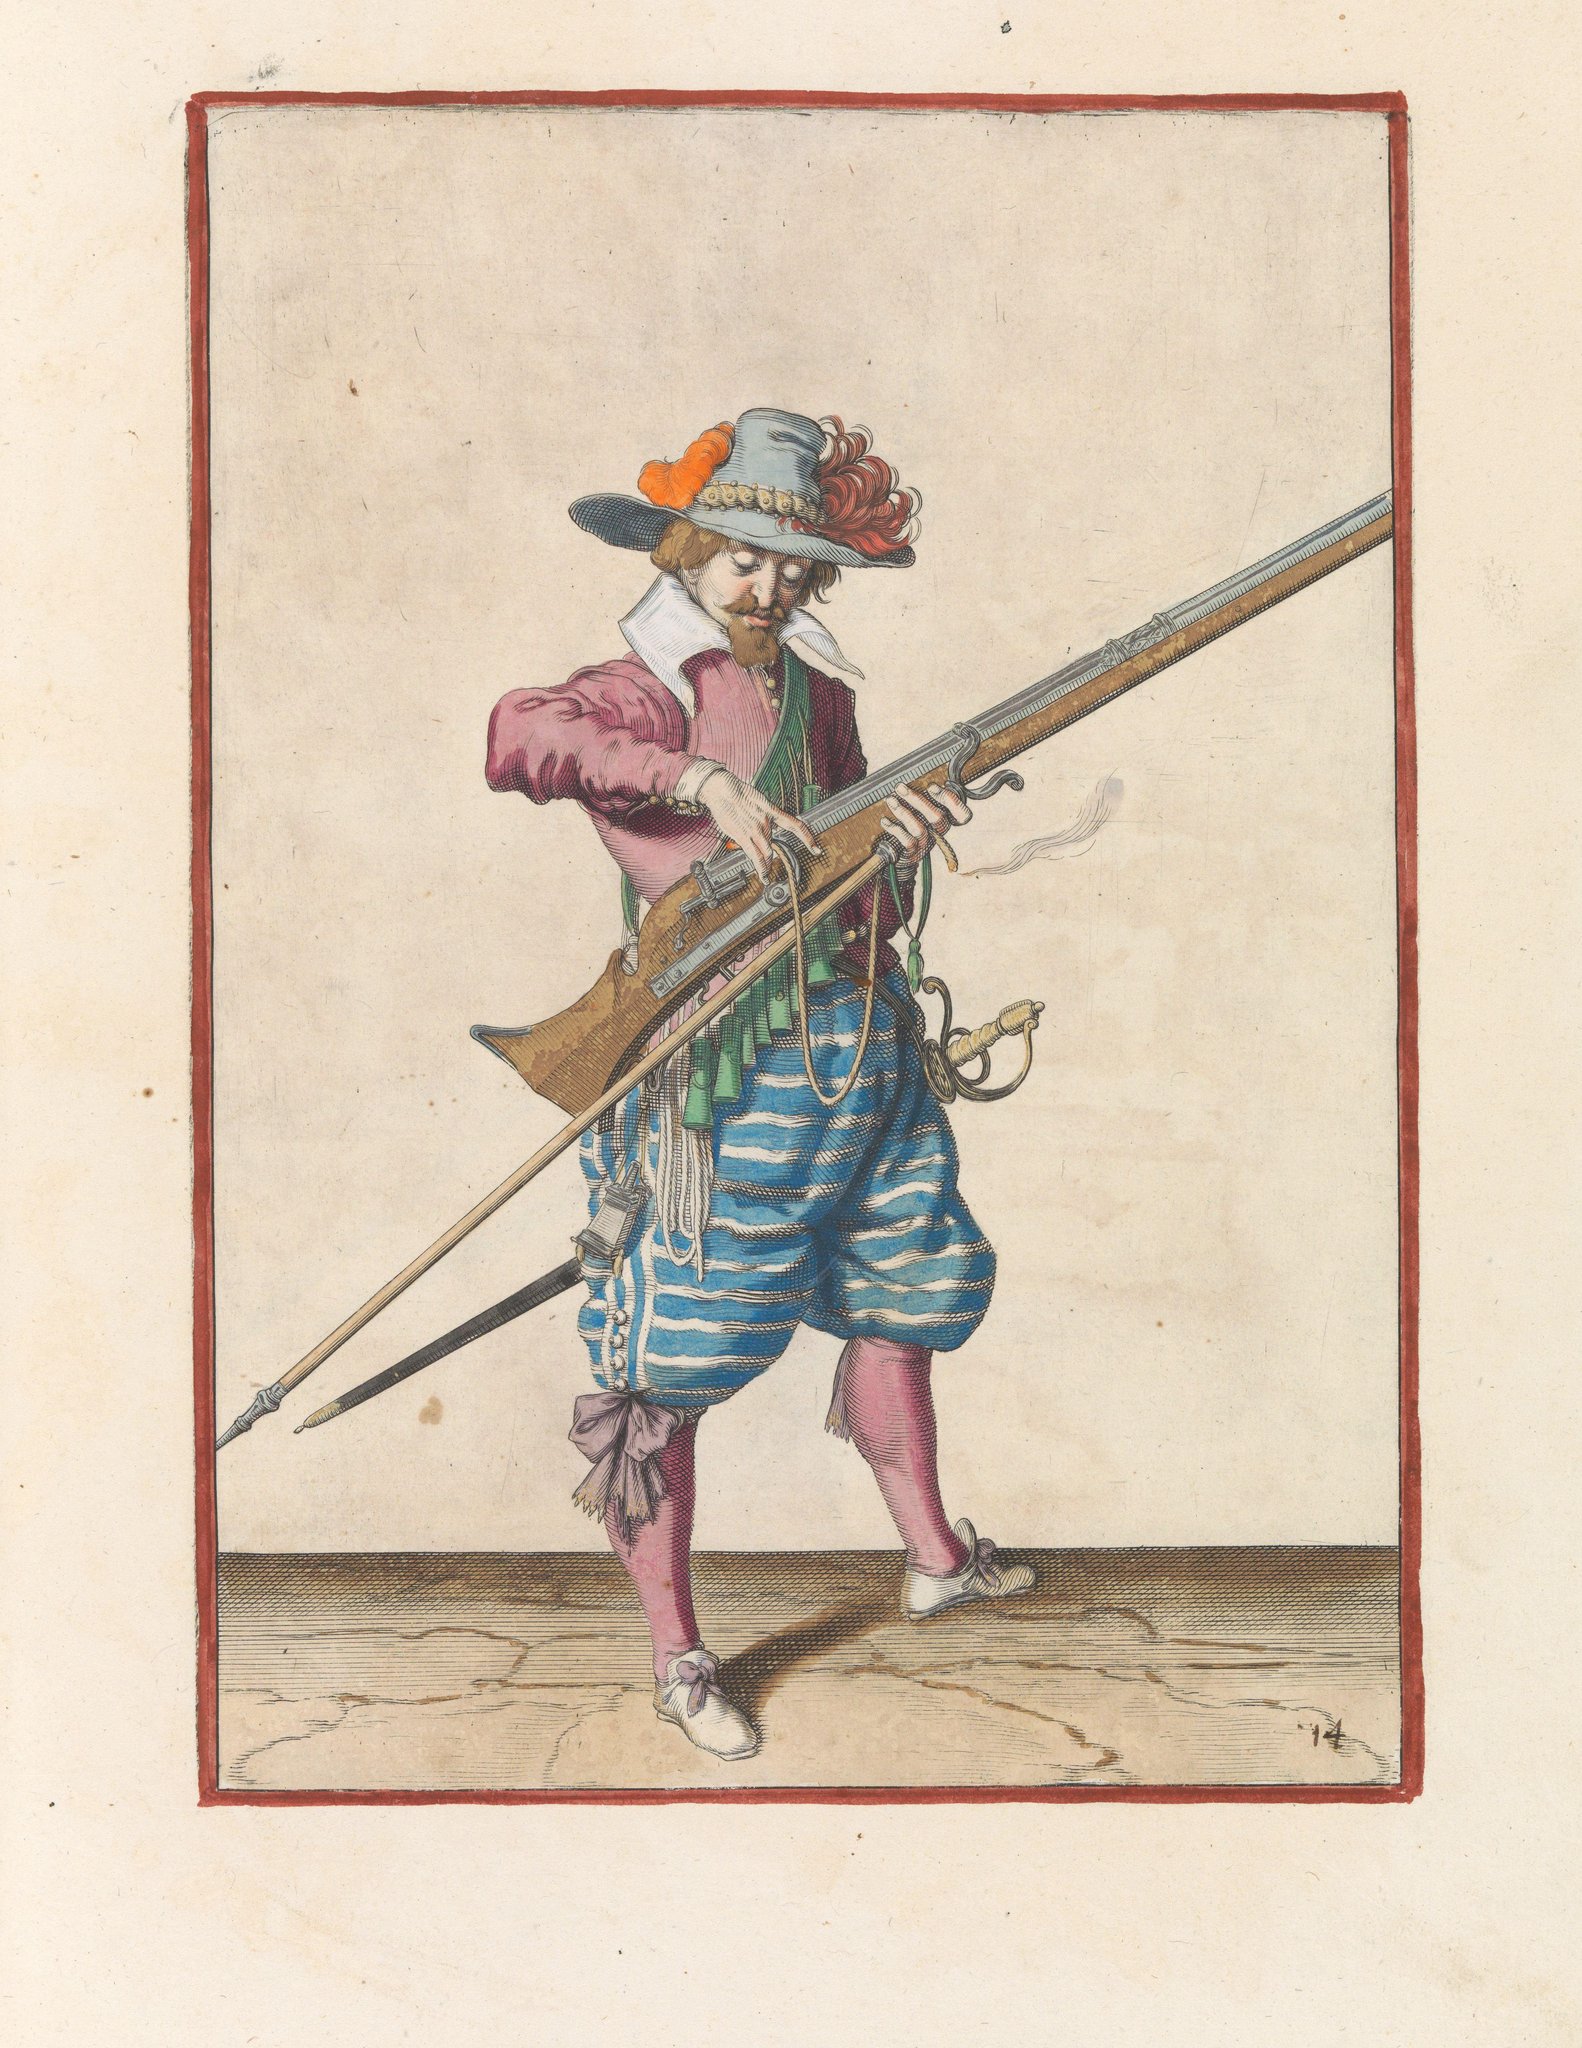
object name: print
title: Corte onderrechtinghe op de figuerliicke afbeeldinghe, soo veel aengaet het recht ghebruyck vant Musquet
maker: jacques de gheyn (ii)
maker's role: painter, print maker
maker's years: 1565-1629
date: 1597-1607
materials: paper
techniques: engraving, hand coloring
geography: the hague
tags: handling of weapons ~ military training, firearms: rifle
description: Een soldaat, ten voeten uit, naar rechts, die een musket (een bepaald type vuurwapen) en een furket (musketvork) met zijn linkerhand vasthoudt. Met zijn rechterhand maakt hij de brandende lont los die op de haan (onderdeel van het ontstekingsmechanisme) van zijn musket ligt. Deze prent is onderdeel van de reeks van 43 met de hand genummerde prenten van musketiers in de Wapenhandelinghe.